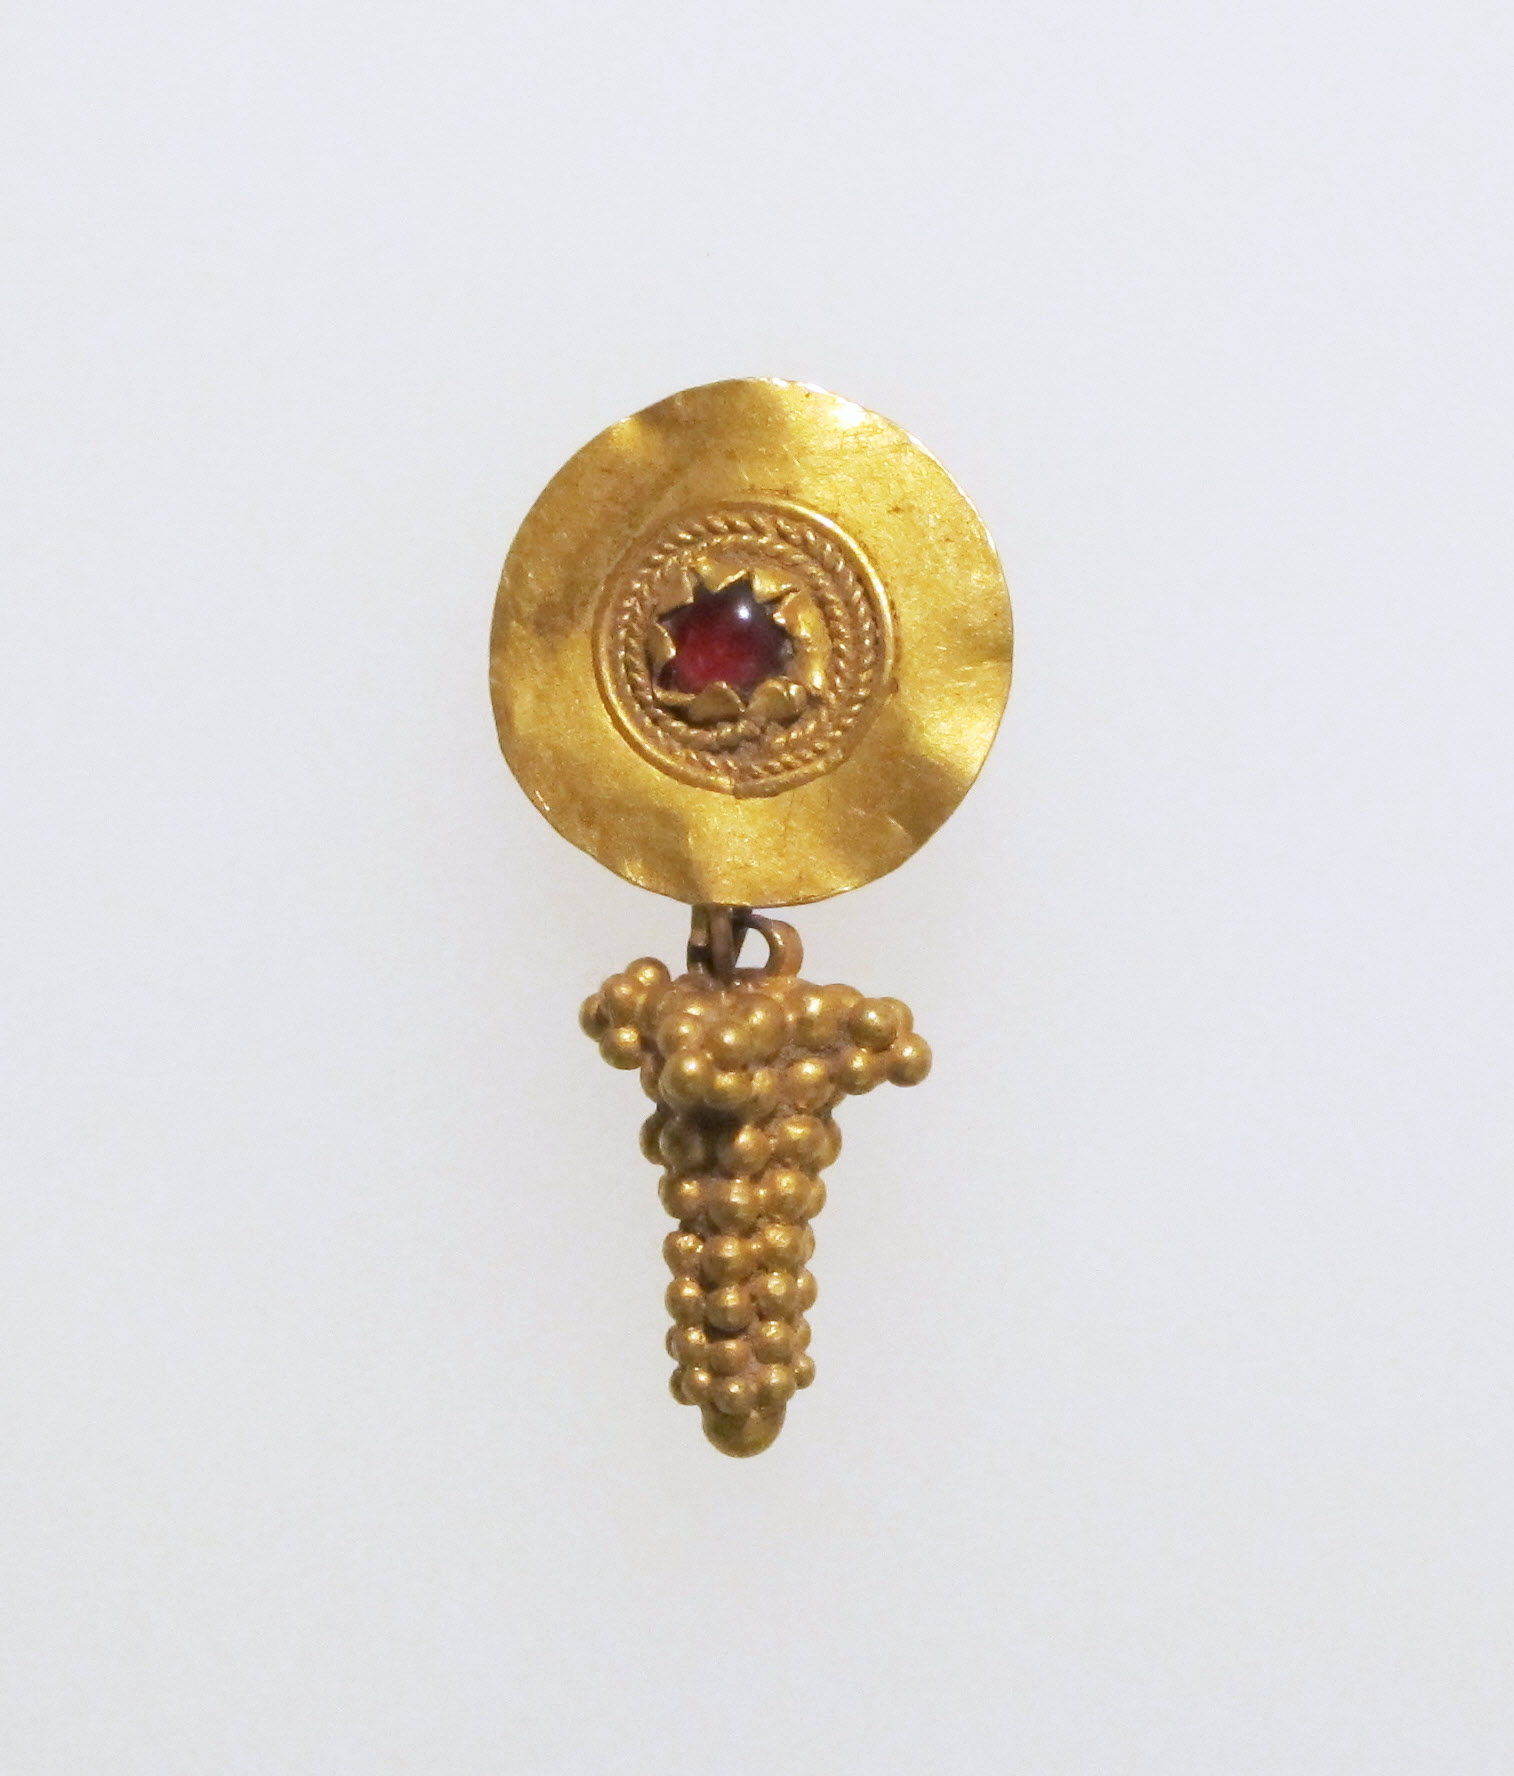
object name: earring with disc, suspended grape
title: Earring with disc, suspended grapes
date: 7000 BCE-330 CE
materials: gemstone, gold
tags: grapes